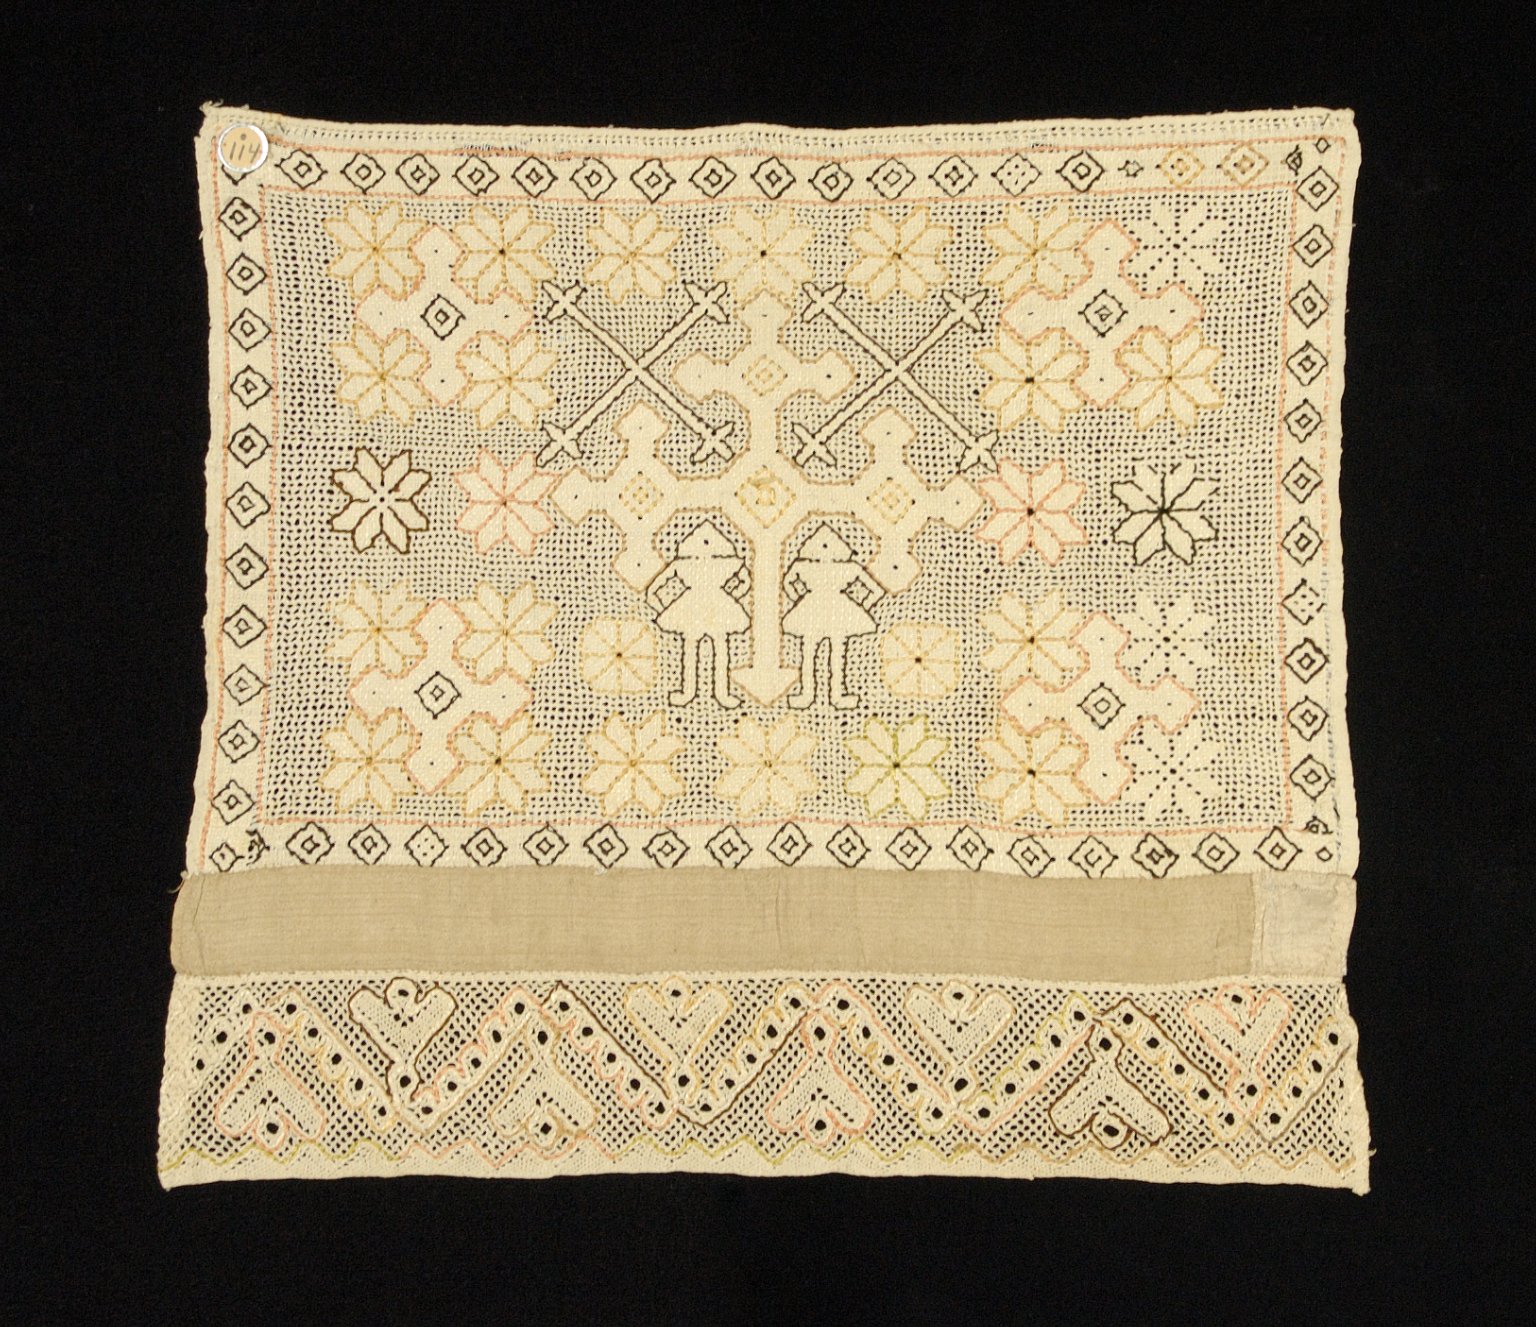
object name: border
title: Towel border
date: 1800-1850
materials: linen, silk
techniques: crochet, embroidery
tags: human figures,flowers